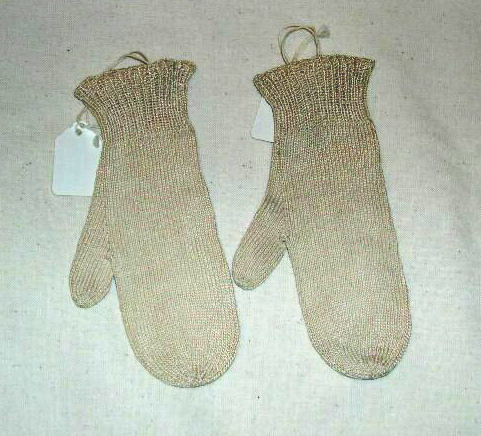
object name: mitten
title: Mittens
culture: american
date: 1801-1900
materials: cotton